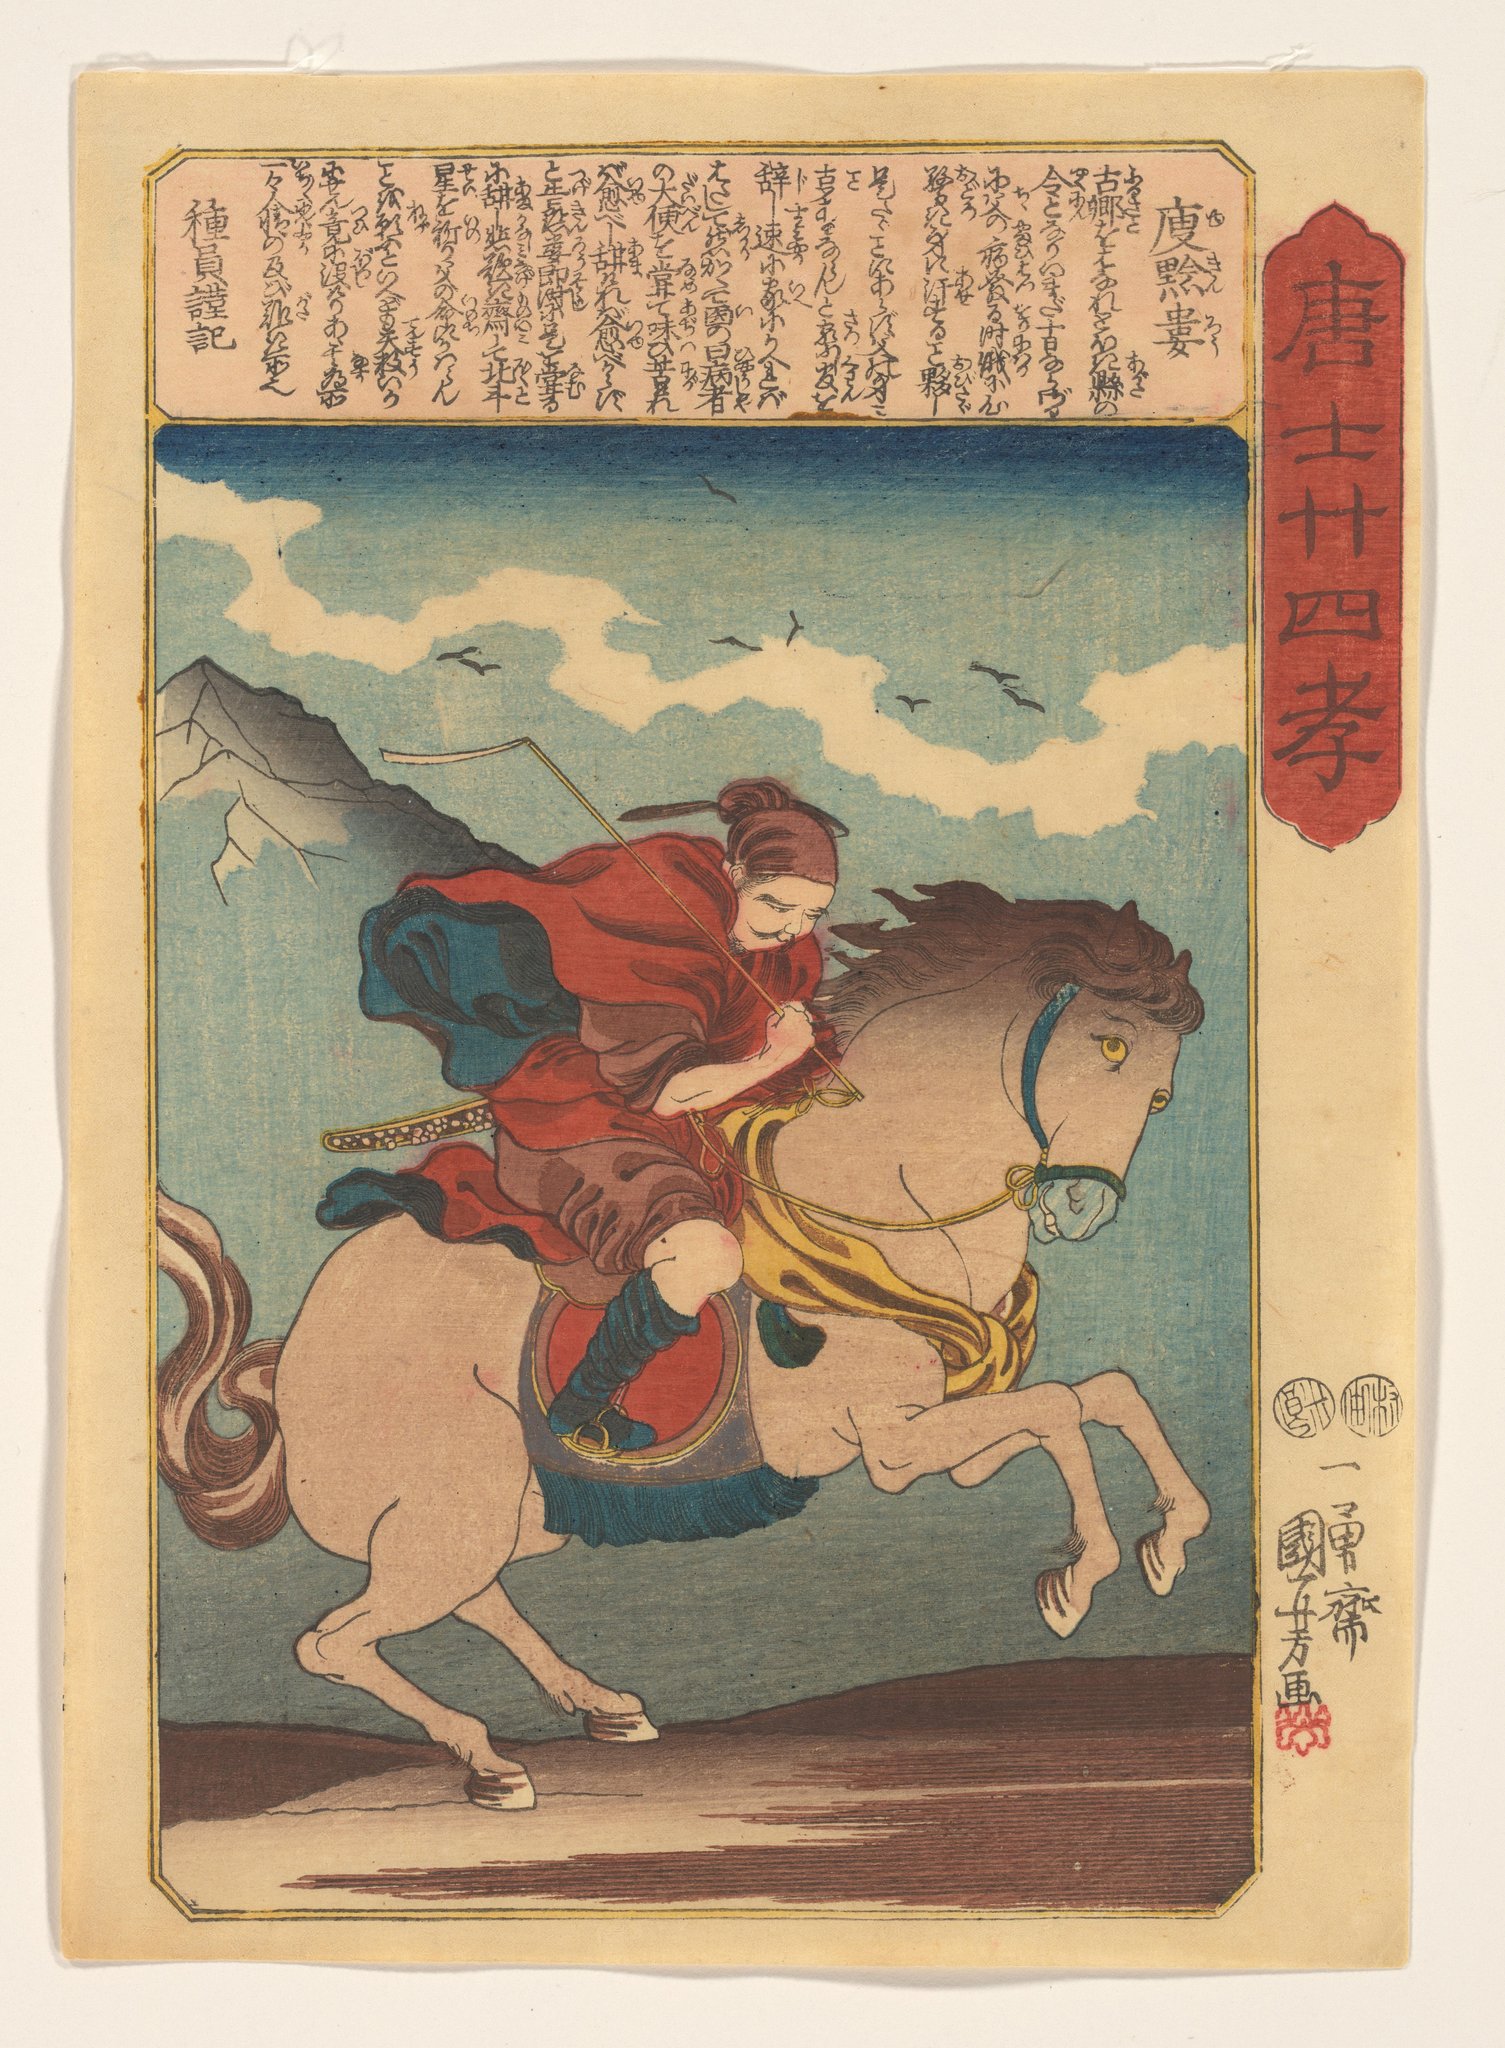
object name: print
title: Yu Kinrô on a horse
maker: utagawa kuniyoshi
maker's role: draughtsman, print maker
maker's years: 1798-1861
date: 1848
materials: paper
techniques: woodcut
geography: japan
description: Yu Kinrô, in Chinese known as Yu Qianlou, rushing home on a horse, after having had a premonition that his aged father was ill. Upon arriving home he found his father on his death bed and was told by a doctor that someone must taste the excrement of the sick man to determine if he would live or die. Yukinrō performed the unpleasant task, and when he learned of his father’s impending demise, prayed all night that he might die in his father’s place. Prints from this series are based on Western examples, some of them which have been traced. This print has a varnish style coating, suggesting an oilpainting.